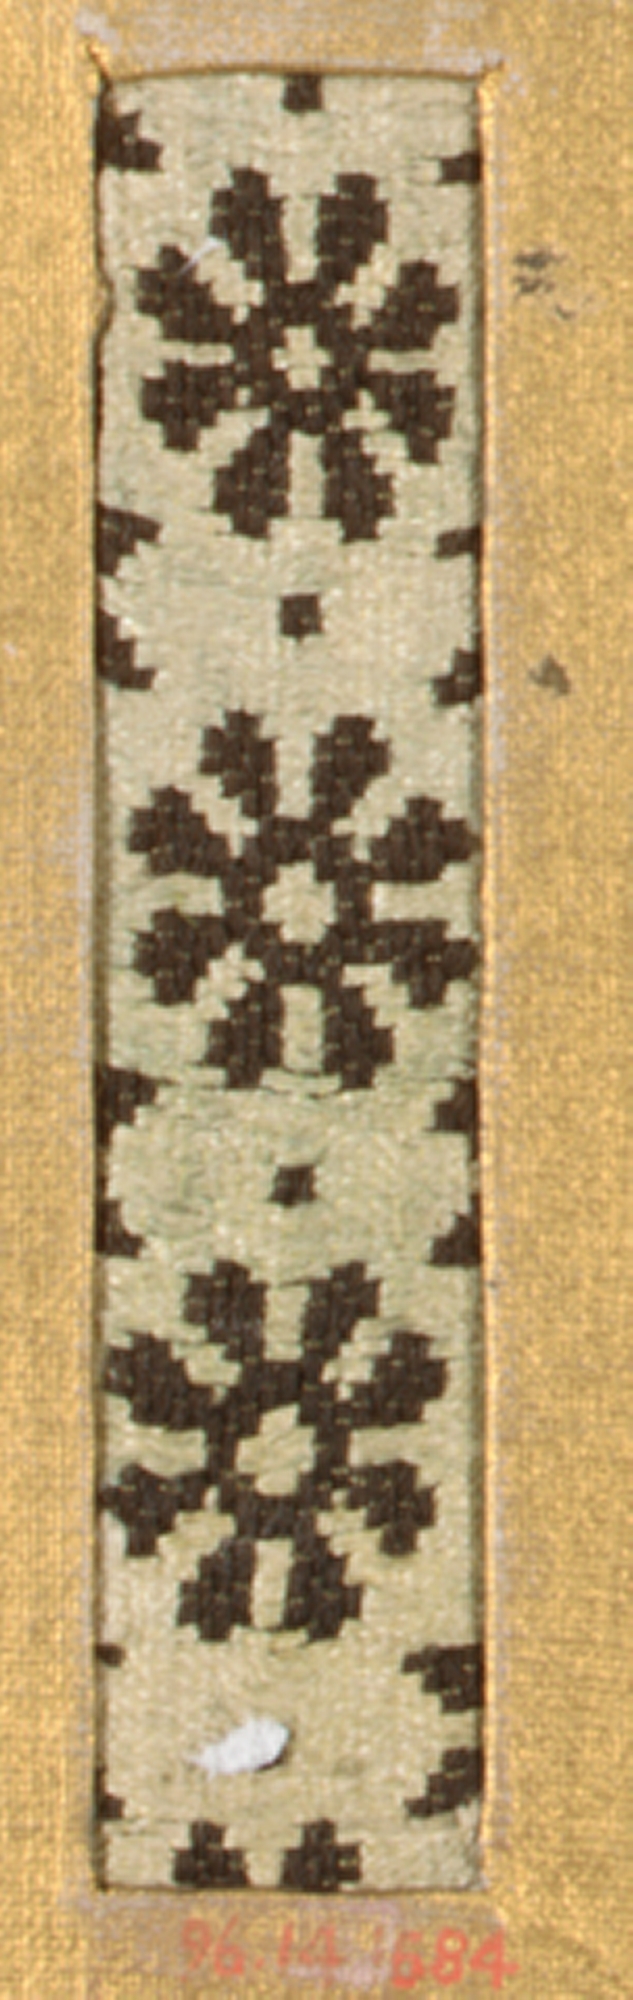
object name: piece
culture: japanese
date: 1701-1900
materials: silk